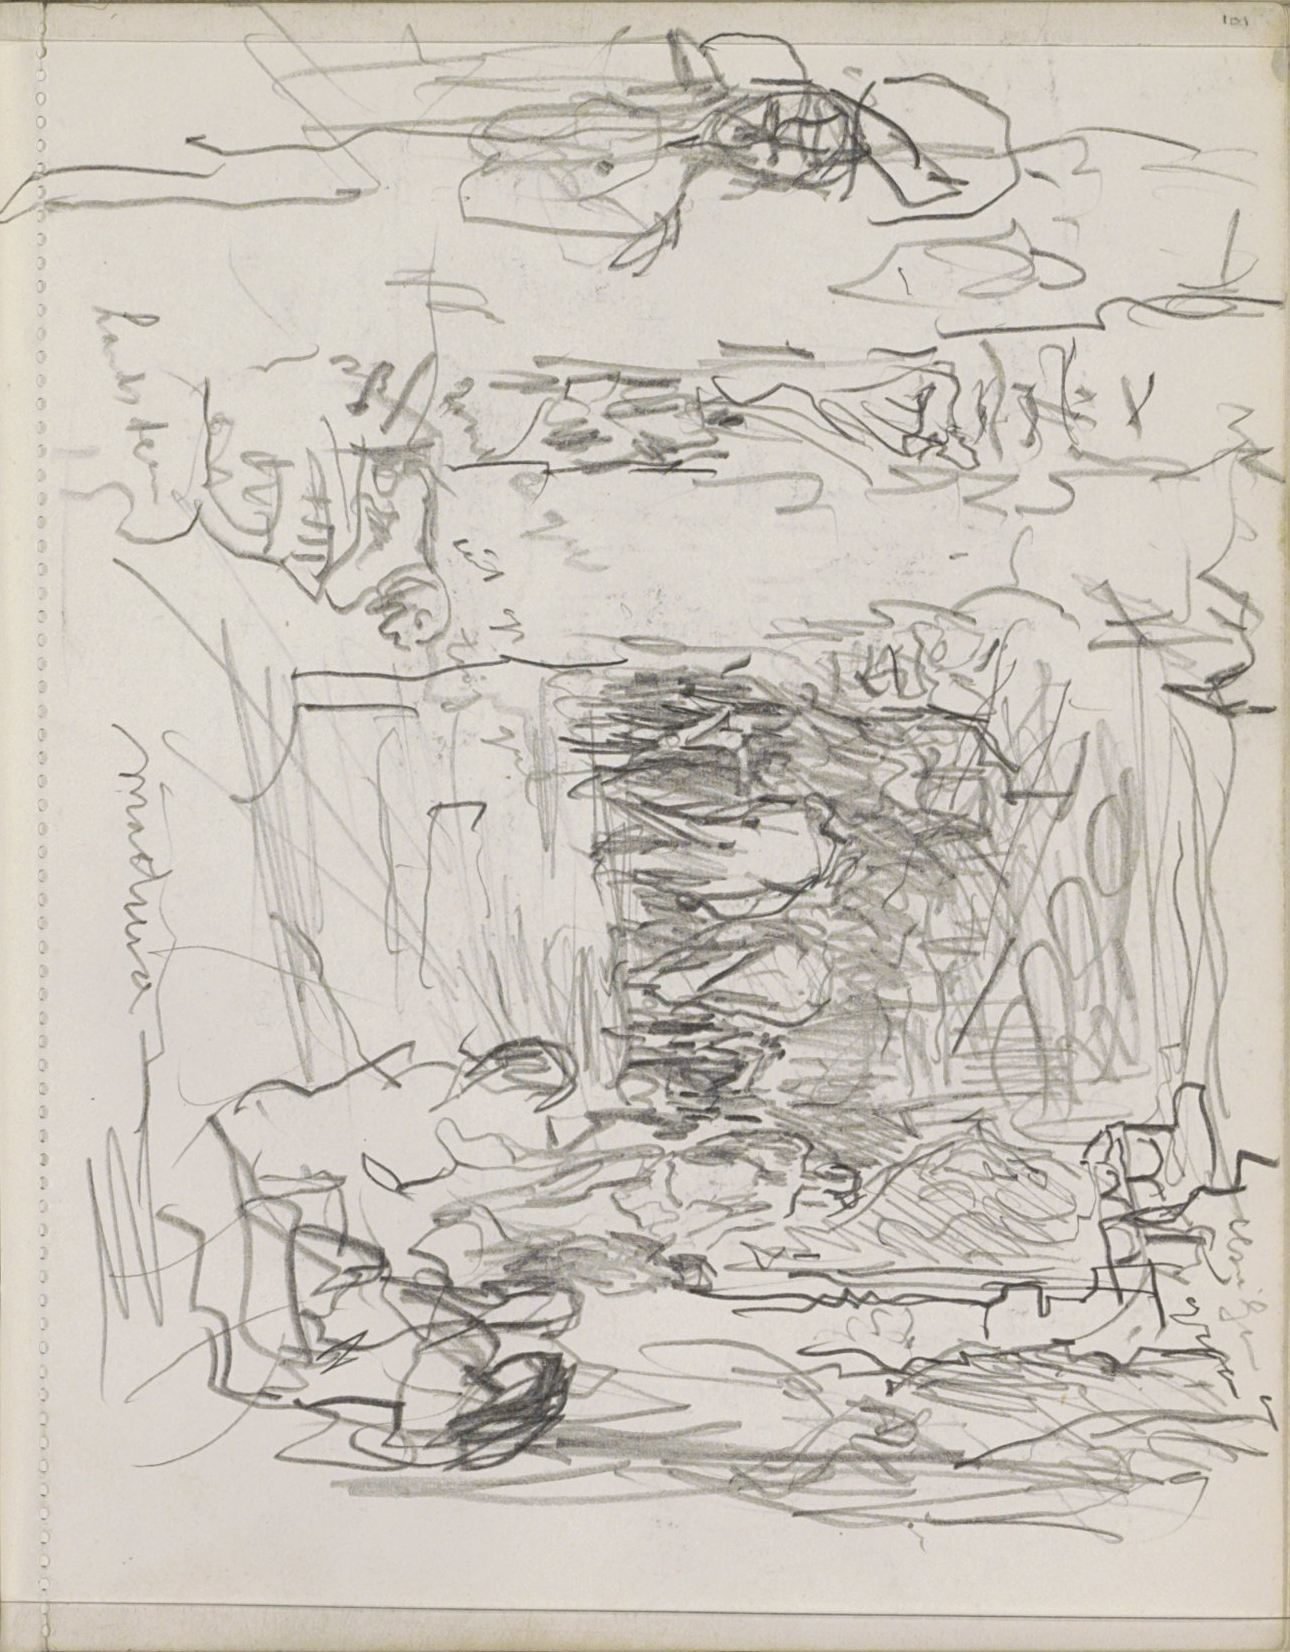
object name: sketchbook leaf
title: Straat met olifanten en figuren in Madurai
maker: marius bauer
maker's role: draughtsman, print maker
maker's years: 1867-1932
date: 1924-1925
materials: paper, pencil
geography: madurai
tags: trunked animals: elephant, street (+ city(-scape) with figures, staffage)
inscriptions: annotation: ‘madura’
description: Pagina 101 uit een schetsboek met 75 bladen.